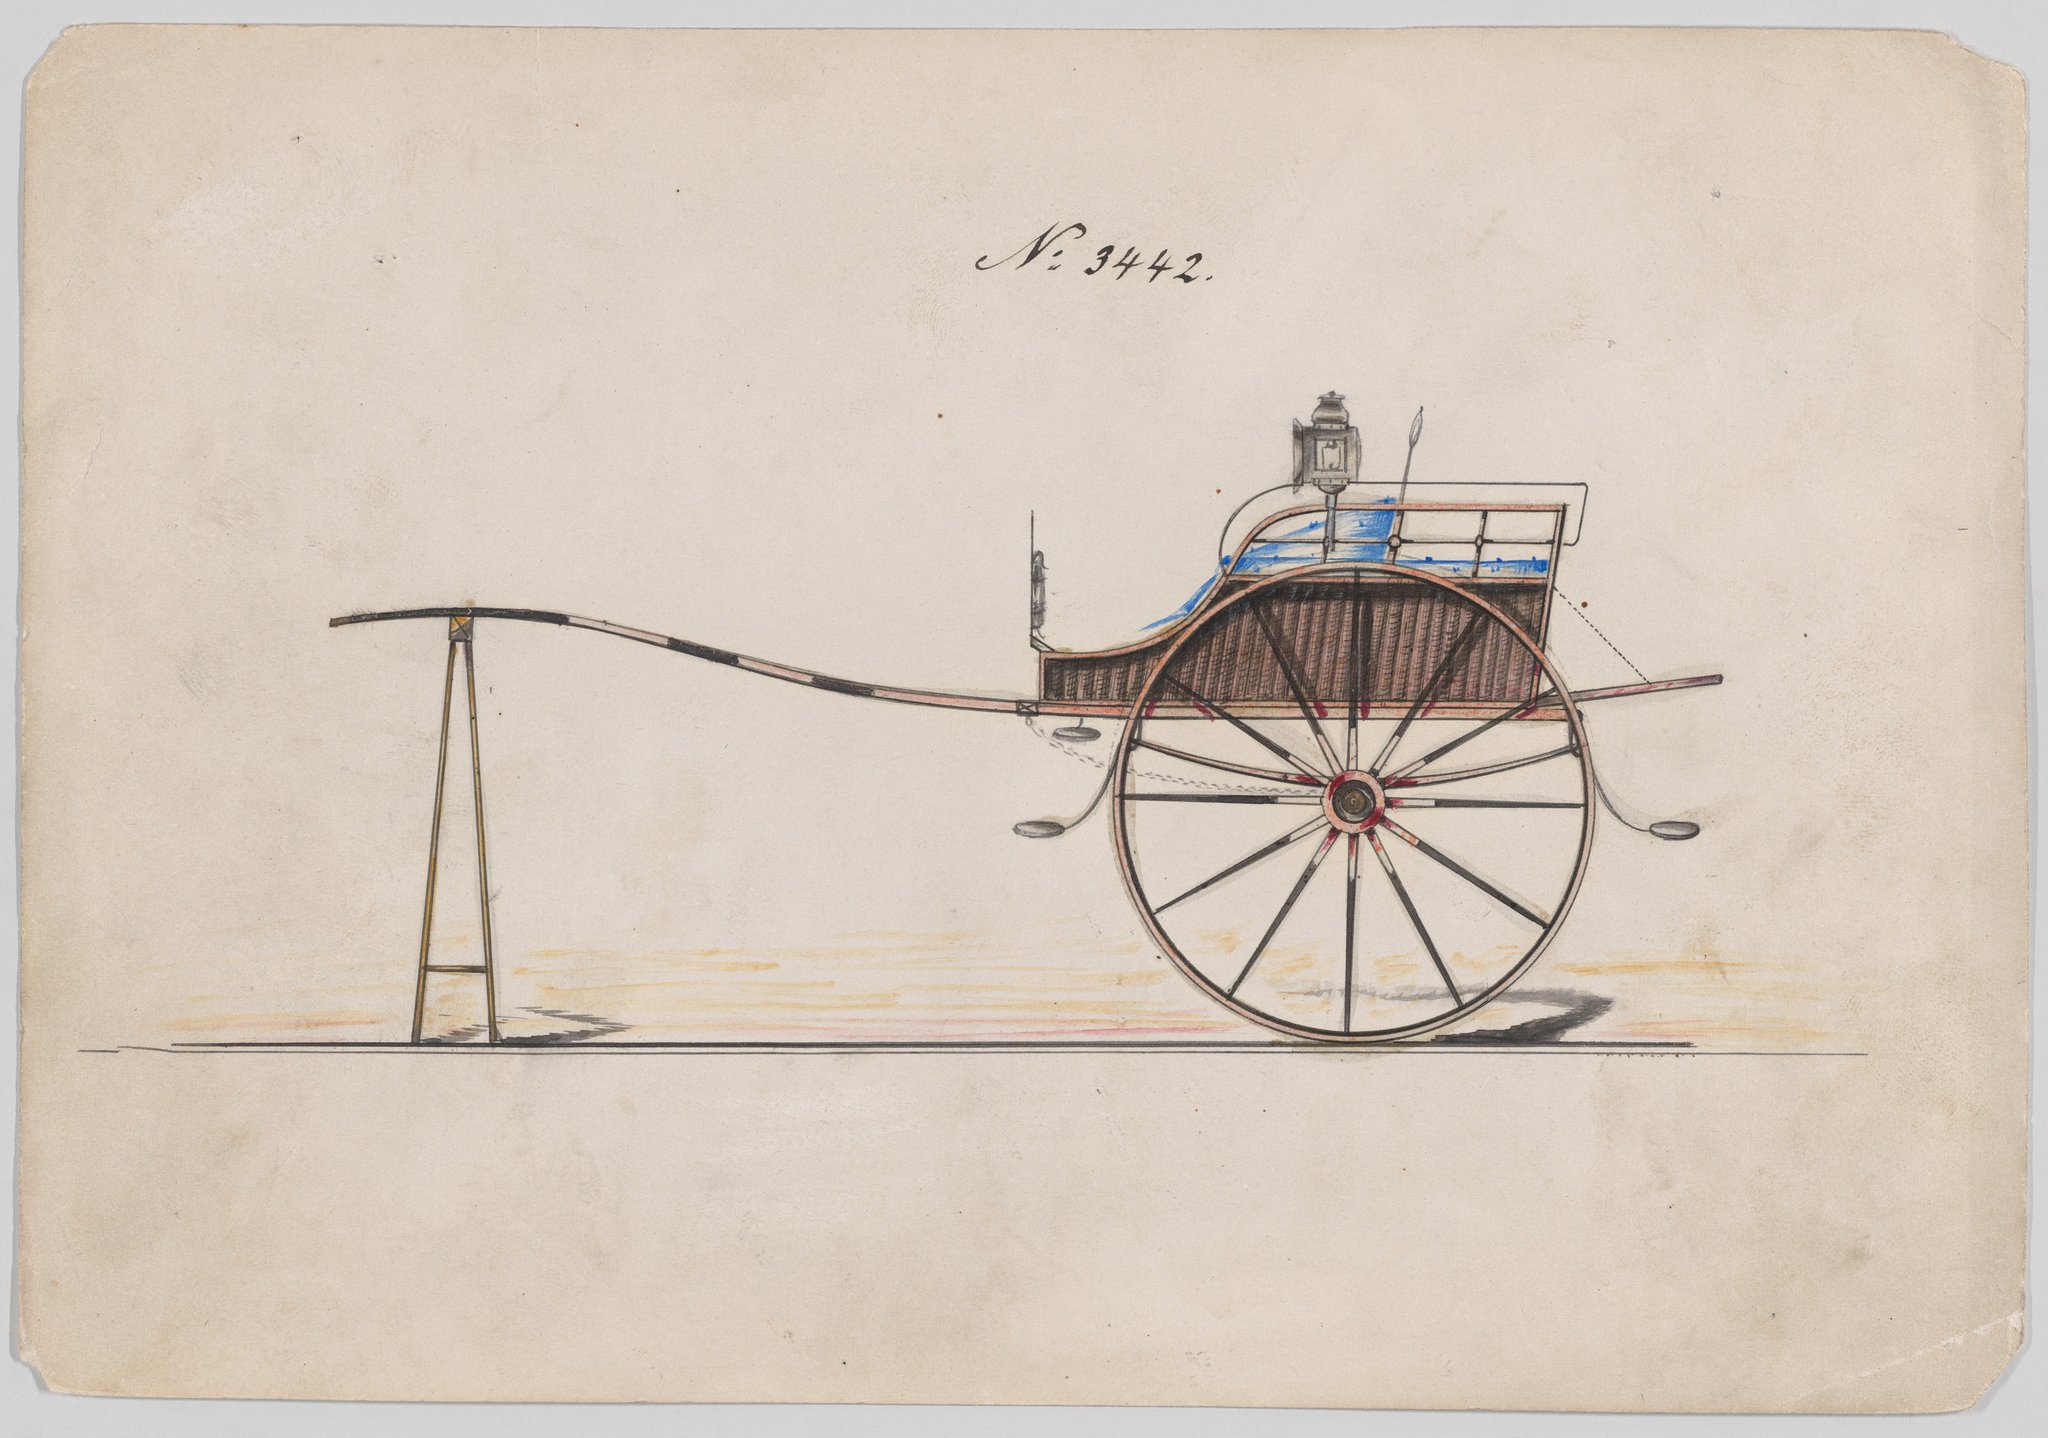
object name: drawing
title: Villiage Cart # 3442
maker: brewster & co.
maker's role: manufacturer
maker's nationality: american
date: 1878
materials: gouache, gum arabic, watercolor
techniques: pen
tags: carriages